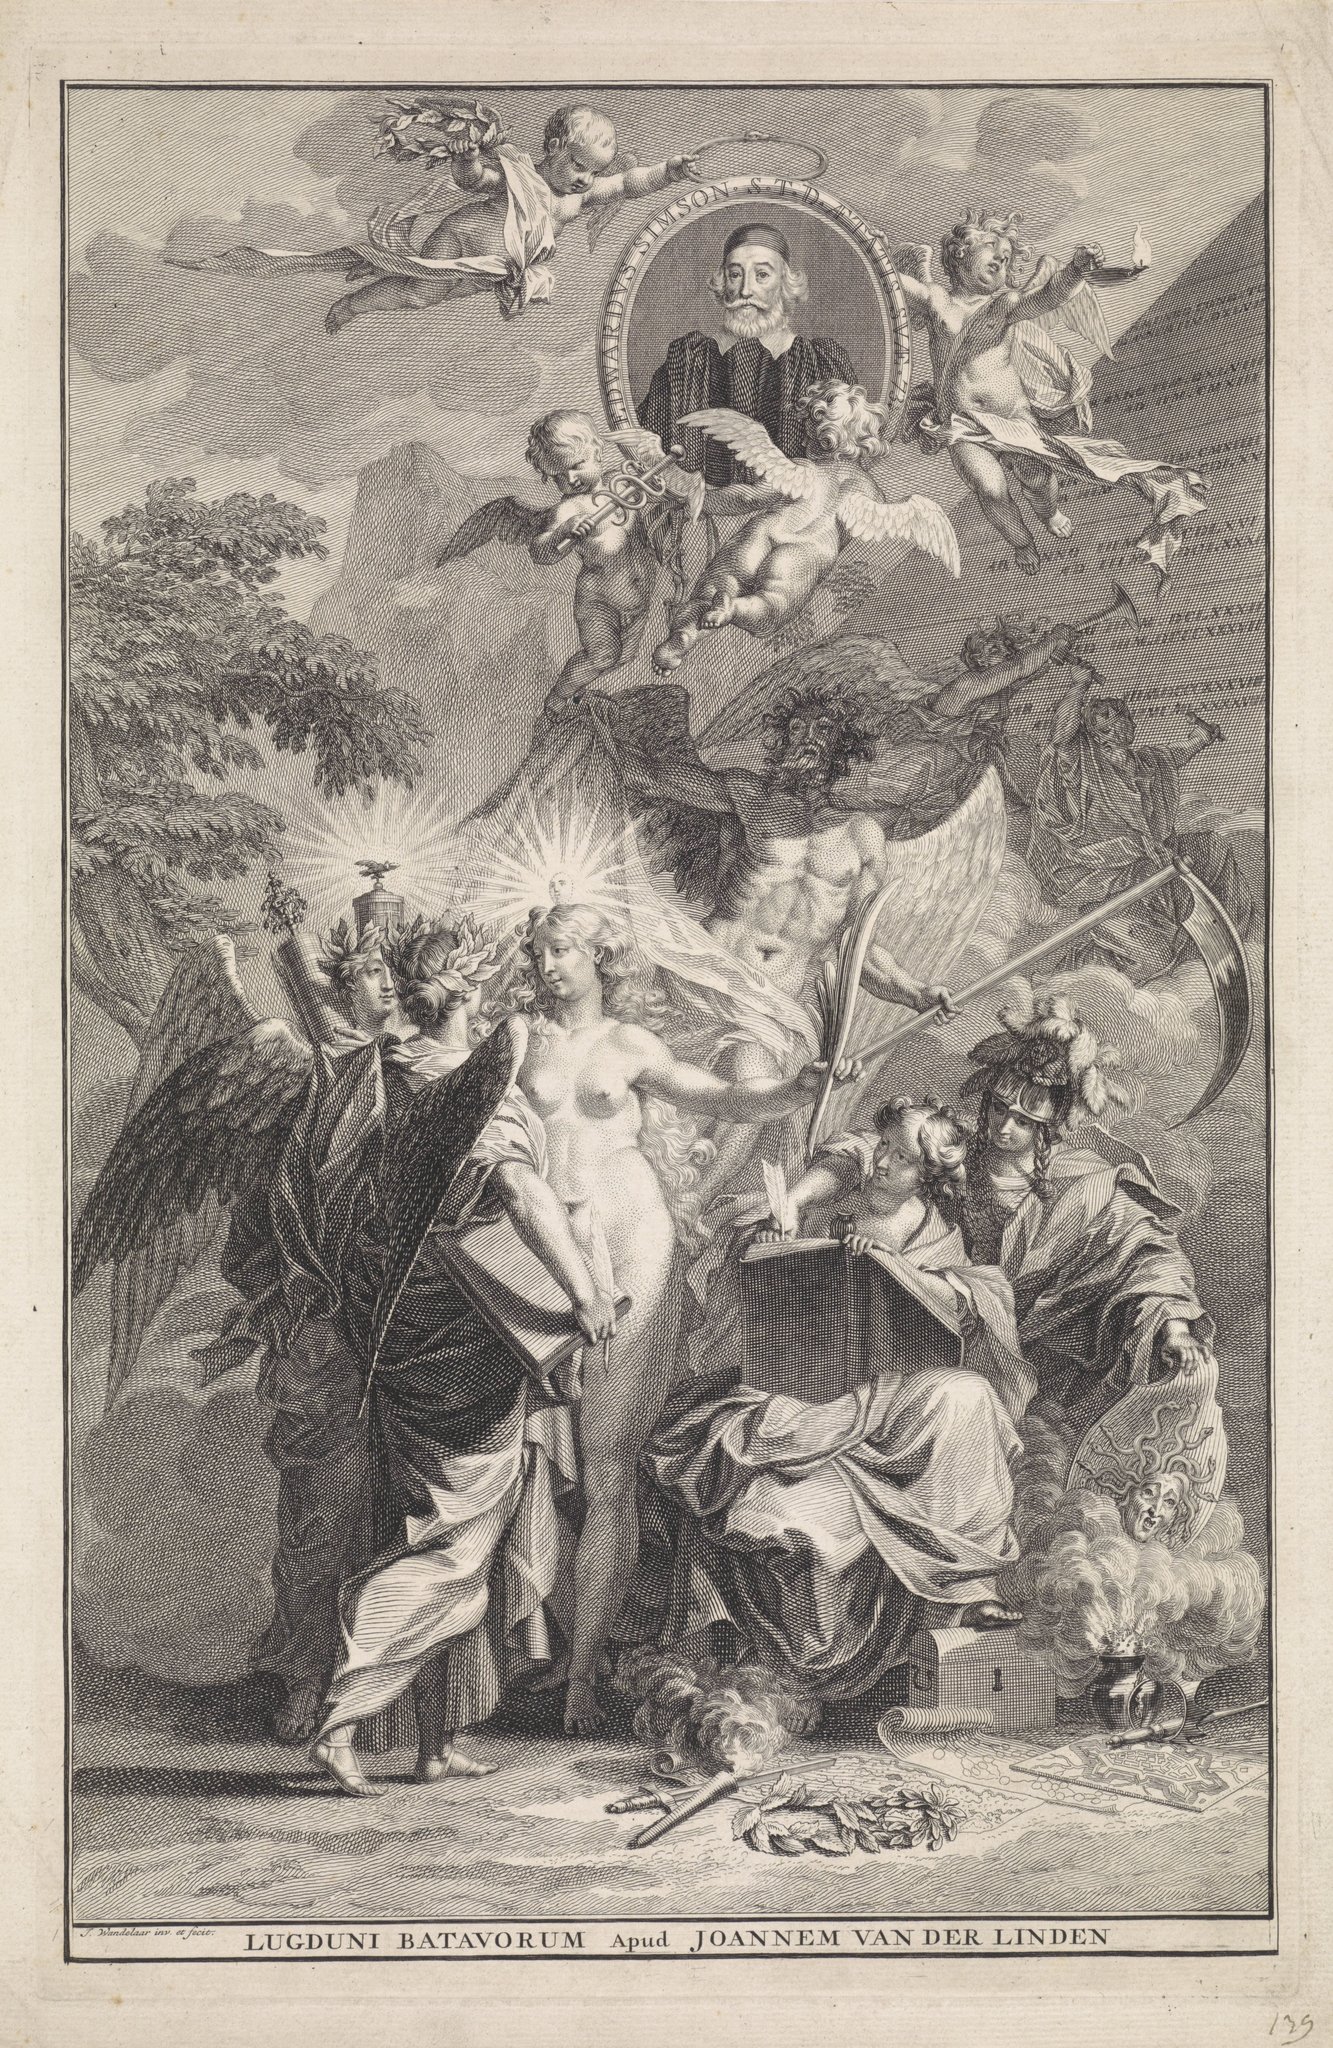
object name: titelblad, titelpagina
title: Allegorische titelpagina met het portret van schrijver Edward Simson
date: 1752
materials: paper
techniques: engraving, etching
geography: leiden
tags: (story of) minerva (pallas, athena), eternity, 'aeternitas'; 'eternità','eternità o perpetuità' (ripa), truth; 'verità' (ripa), symbolic representations, allegories and emblems ~ poetry; 'poesia' (ripa), pyramid (historical grave form), 'historia'; 'historia' (ripa), fame; 'fama', 'fama buona', 'fama chiara' (ripa), father time, man with wings and scythe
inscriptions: number: ‘139’, collector's mark: Lugt 2228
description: Minerva zit naast Geschiedenis en kijkt over haar schouder mee naar het boek waarin zij schrijft. Geschiedenis kijkt op naar drie allegorische vrouwfiguren (Waarheid, Poëzie en een derde figuur). Achter hen Vader Tijd, Faam en een tweehoofdige figuur die met een beitel een inscriptie slaat in een piramide. In de lucht vliegen vier putti, met eeuwigheidsymbolen in de handen, die het portret van schrijver Edward Simson meevoeren.